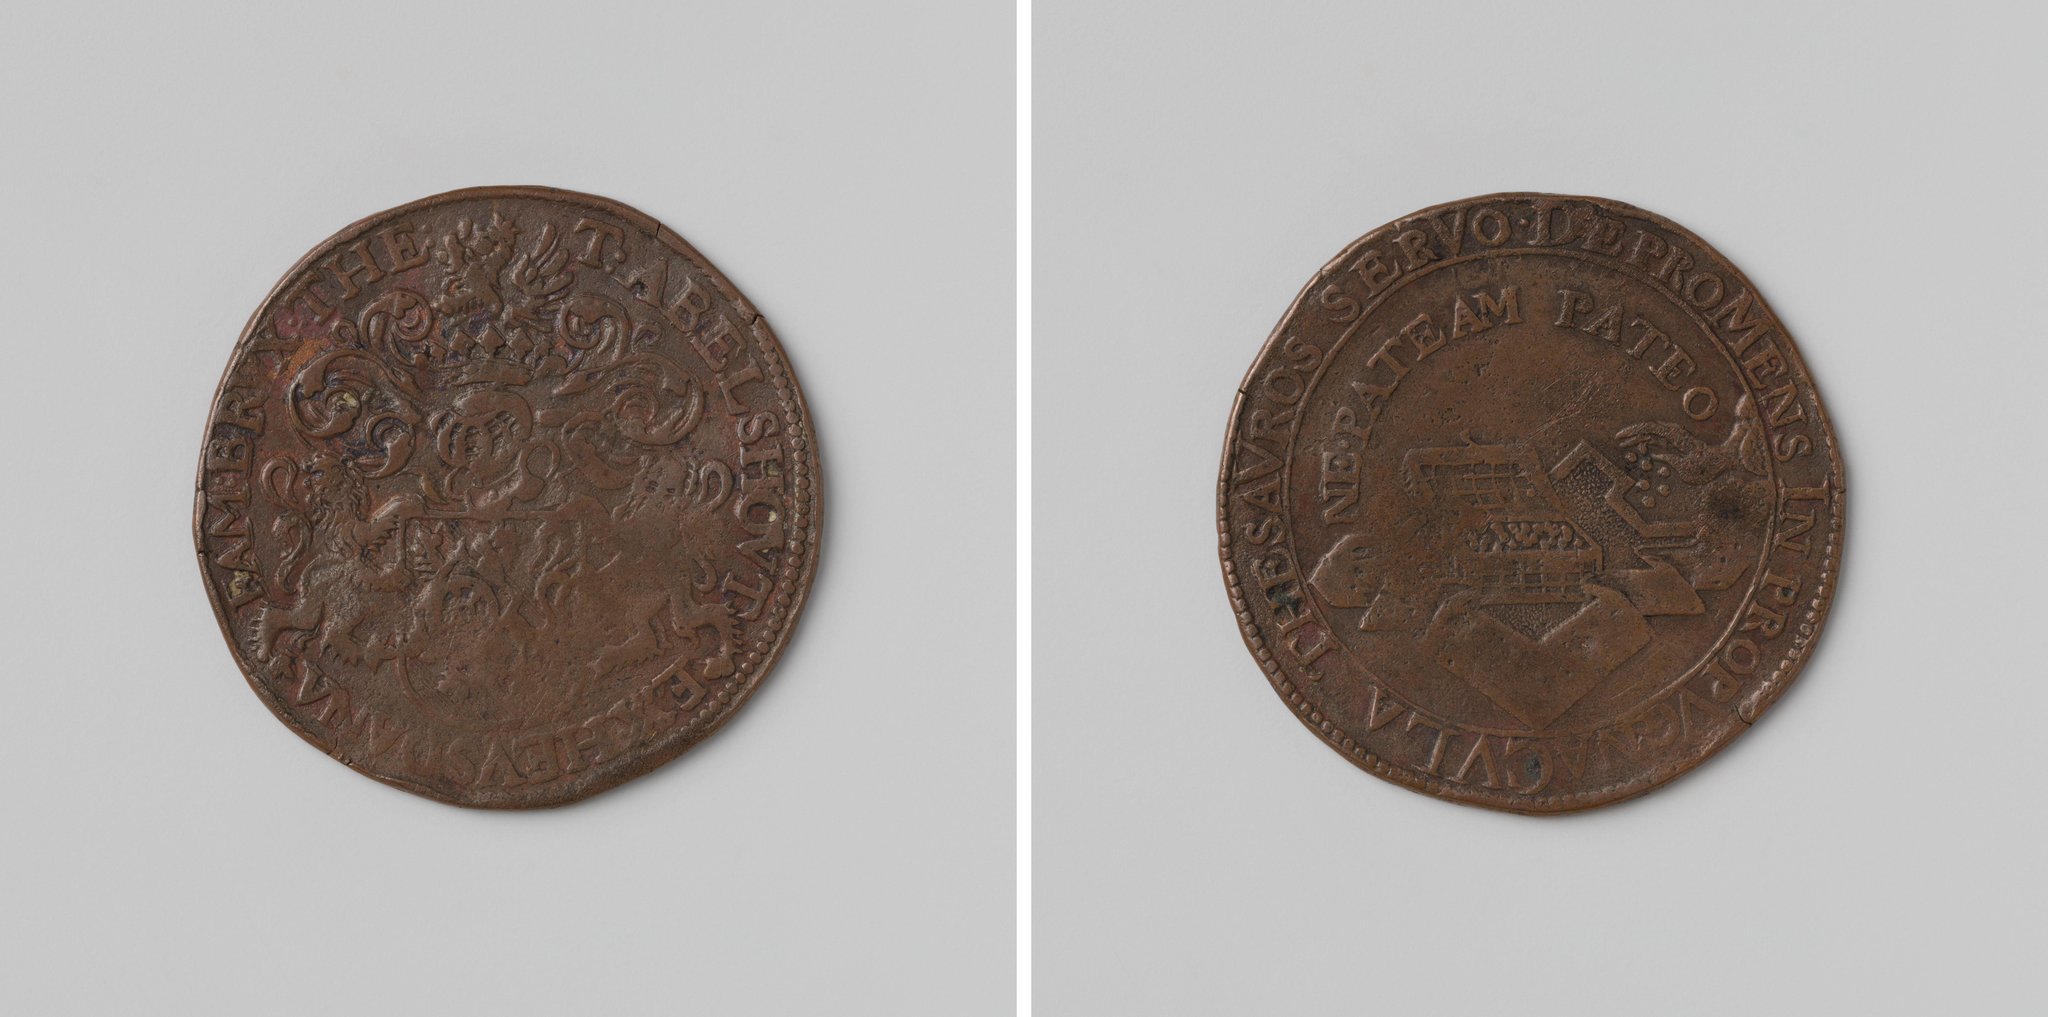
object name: jeton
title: Versterking van de veredigingswerken van Brussel en bouw van een fort, rekenpenning van Theodore d'Elshout-Van Heusden, heer van Middelswale, magistraat van de schatkist van Brussel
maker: Anonymous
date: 1601-1671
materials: copper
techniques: striking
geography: brussels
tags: brussels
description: Koperen penning. Voorzijde: gehelmd wapenschild, geflankeerd door twee leeuwen binnen omschrift. Keerzijde: hand uit wolken werpt geld in geopende geldkist, staande binnen muren van bastion binnen tweeregelig omschrift